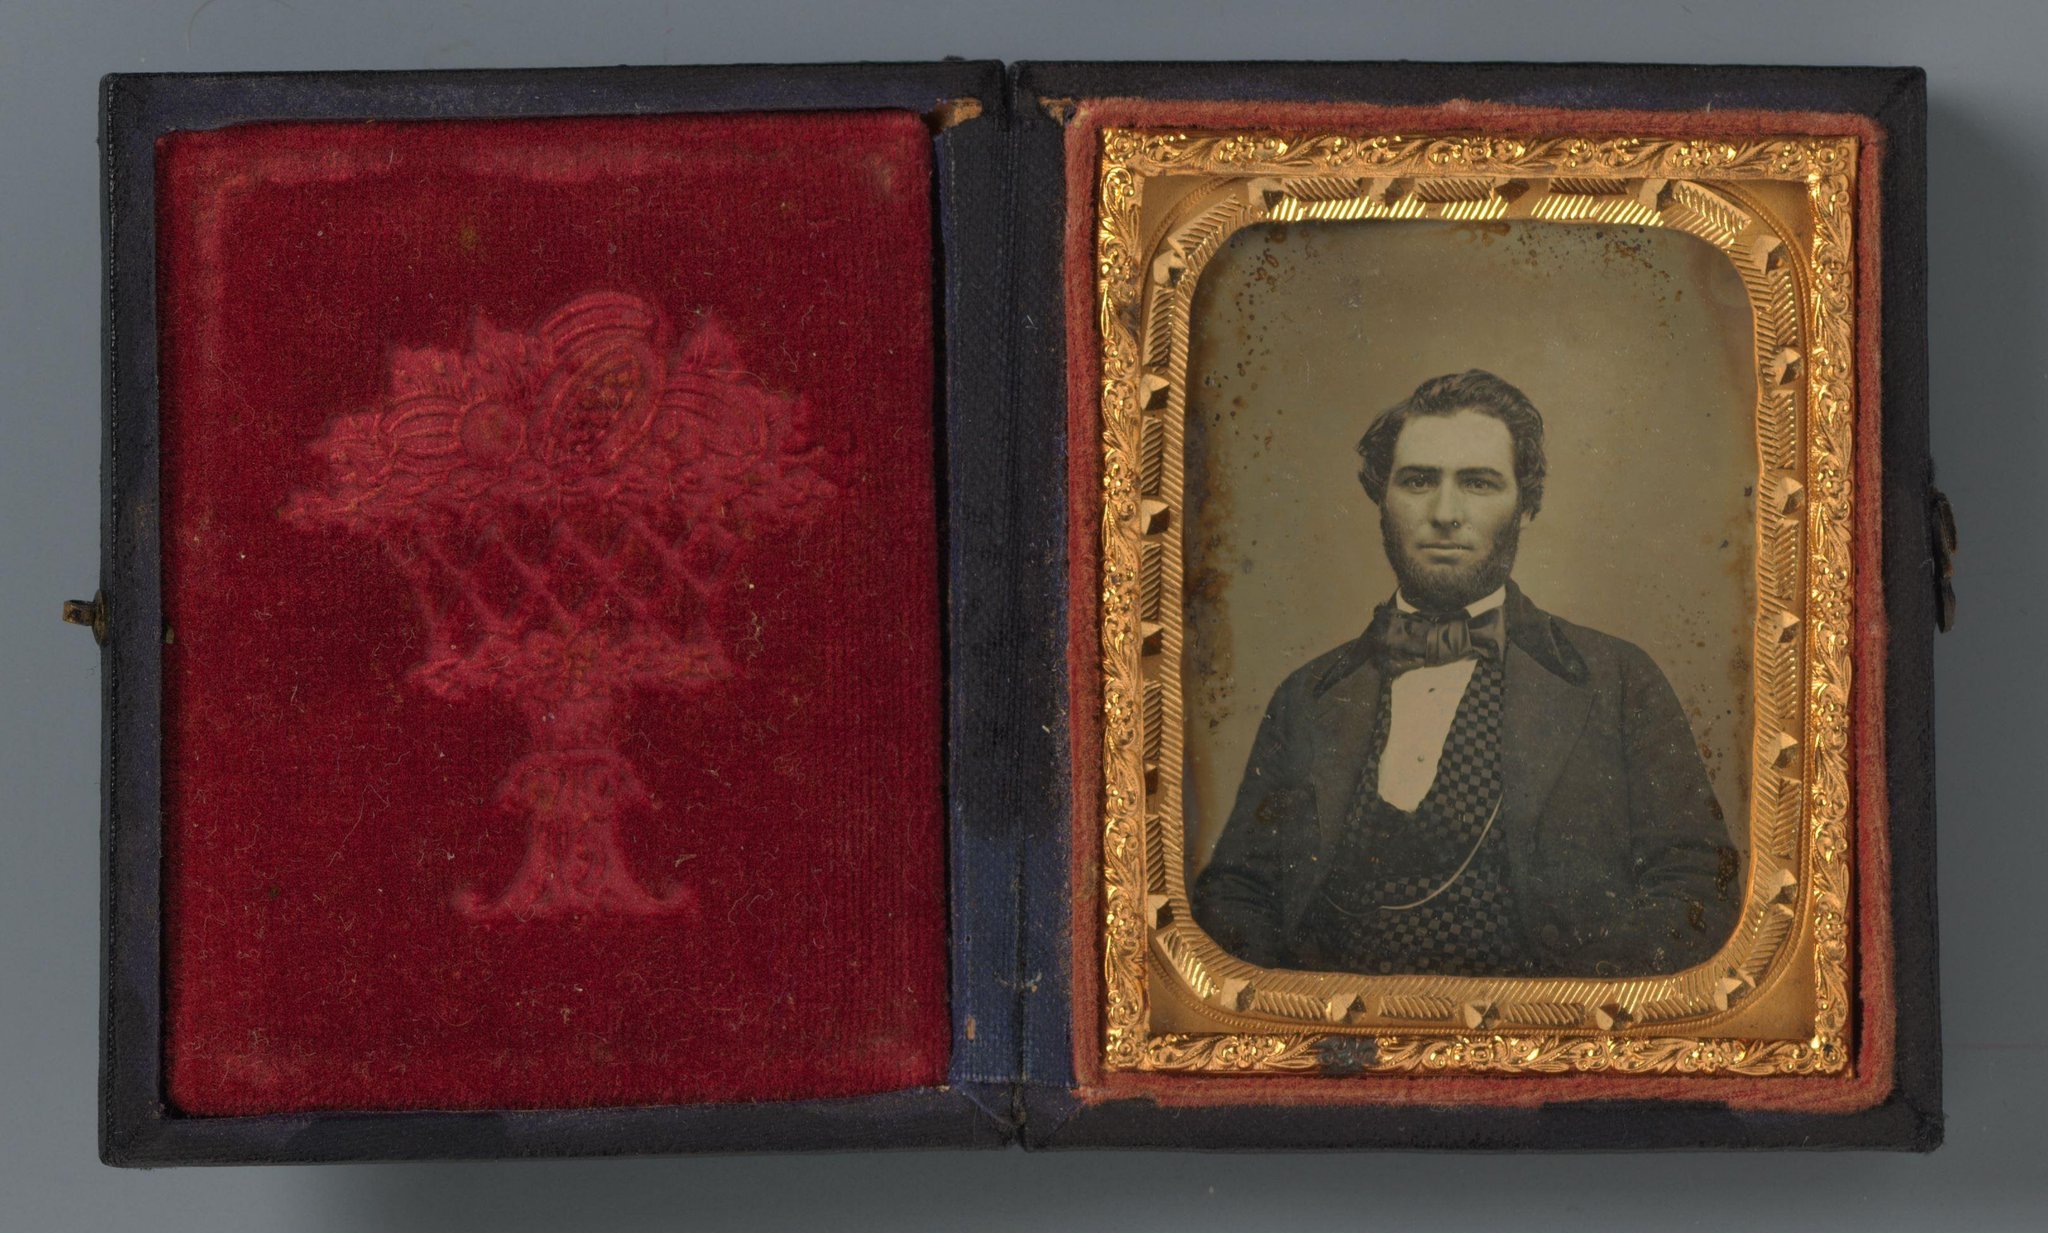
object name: photograph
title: Portret van een onbekende man met baard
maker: Anonymous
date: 1840-1860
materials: copper, glass, leather, velvet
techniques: daguerreotype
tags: adult man, historical persons